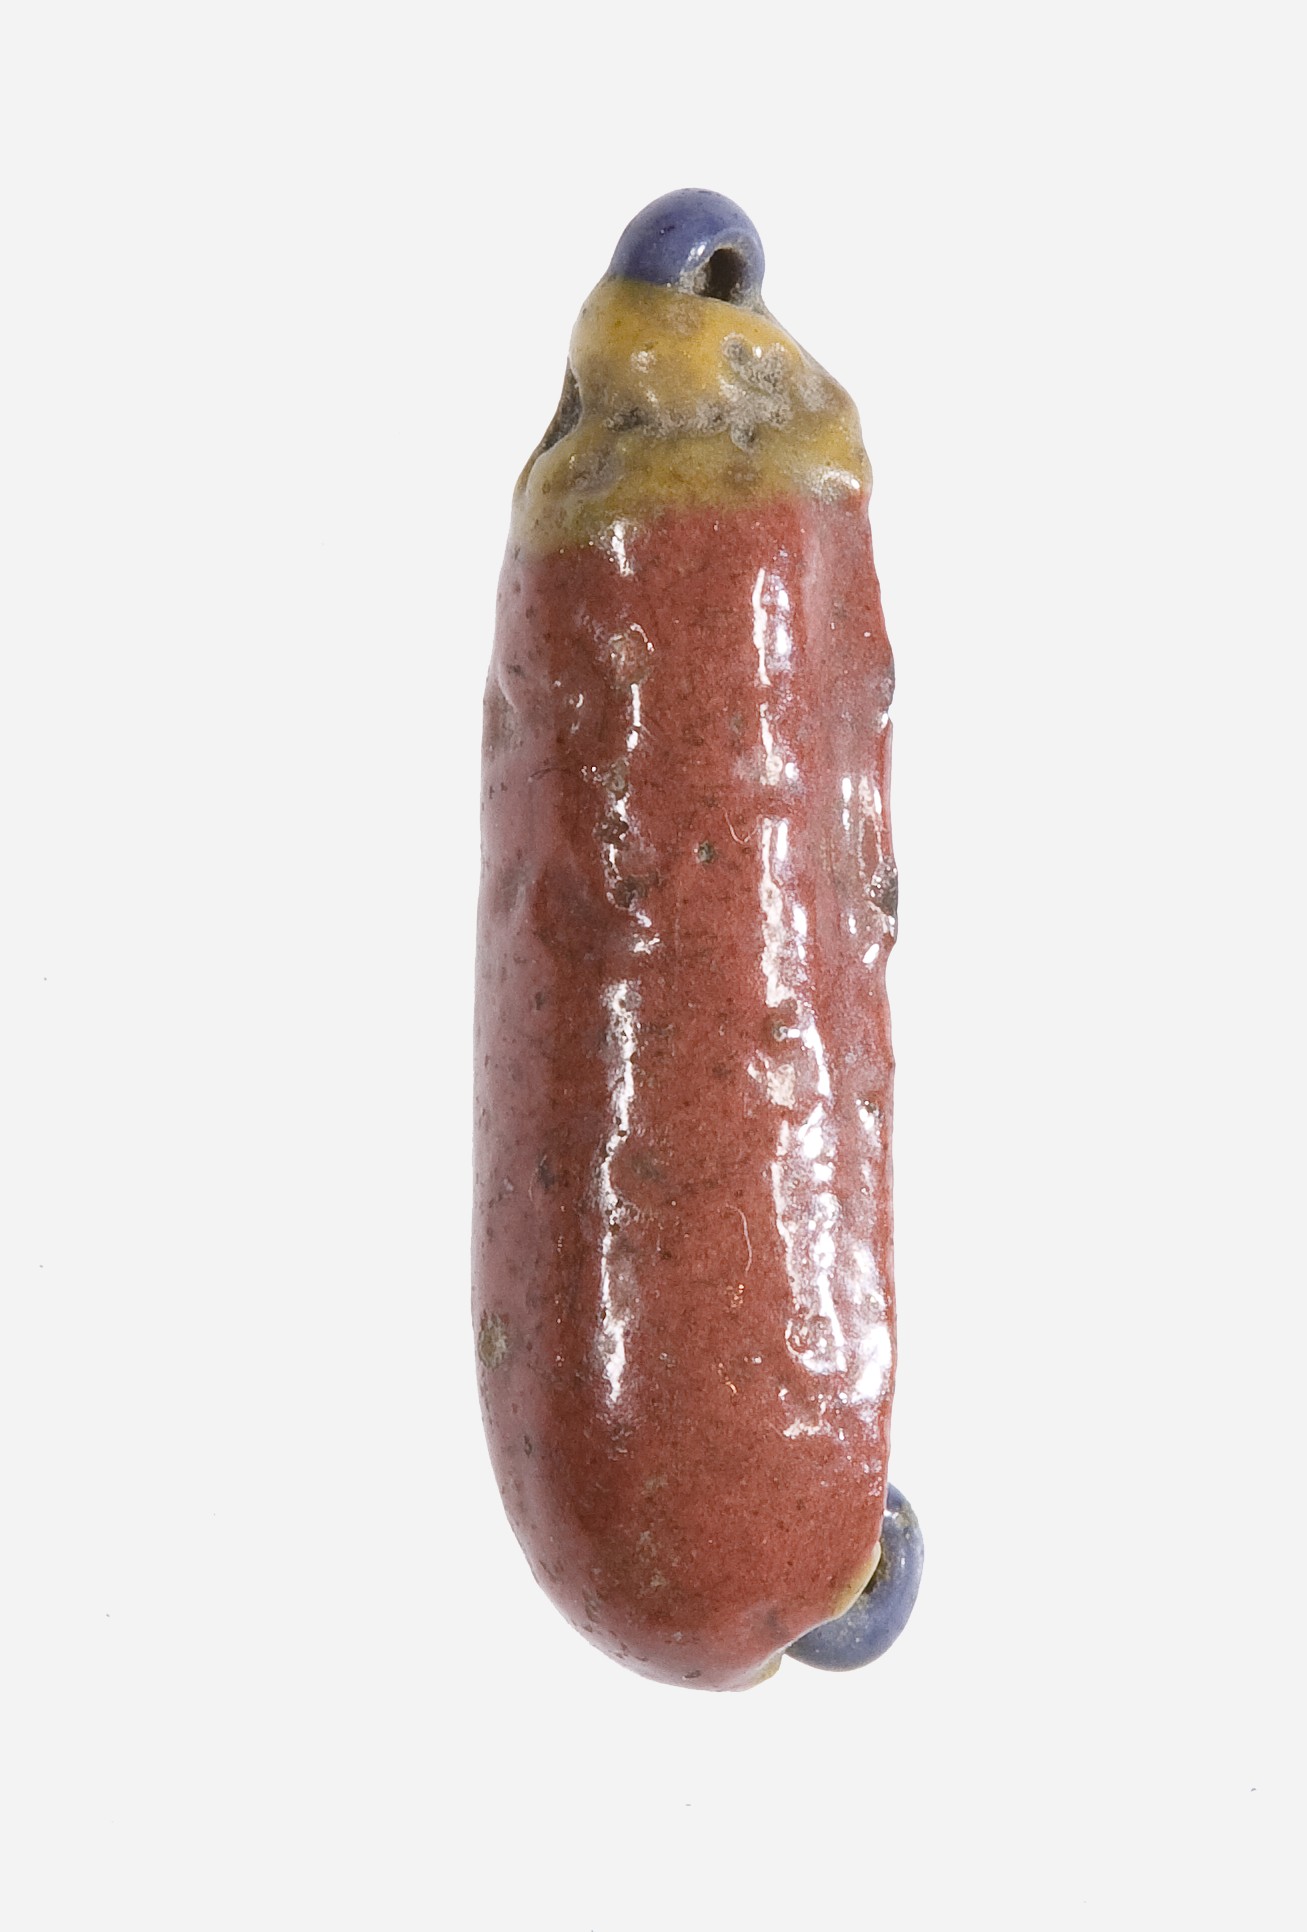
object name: pendant, date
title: Date Pendant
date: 1390-1352 BCE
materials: faience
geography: egypt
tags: fruit